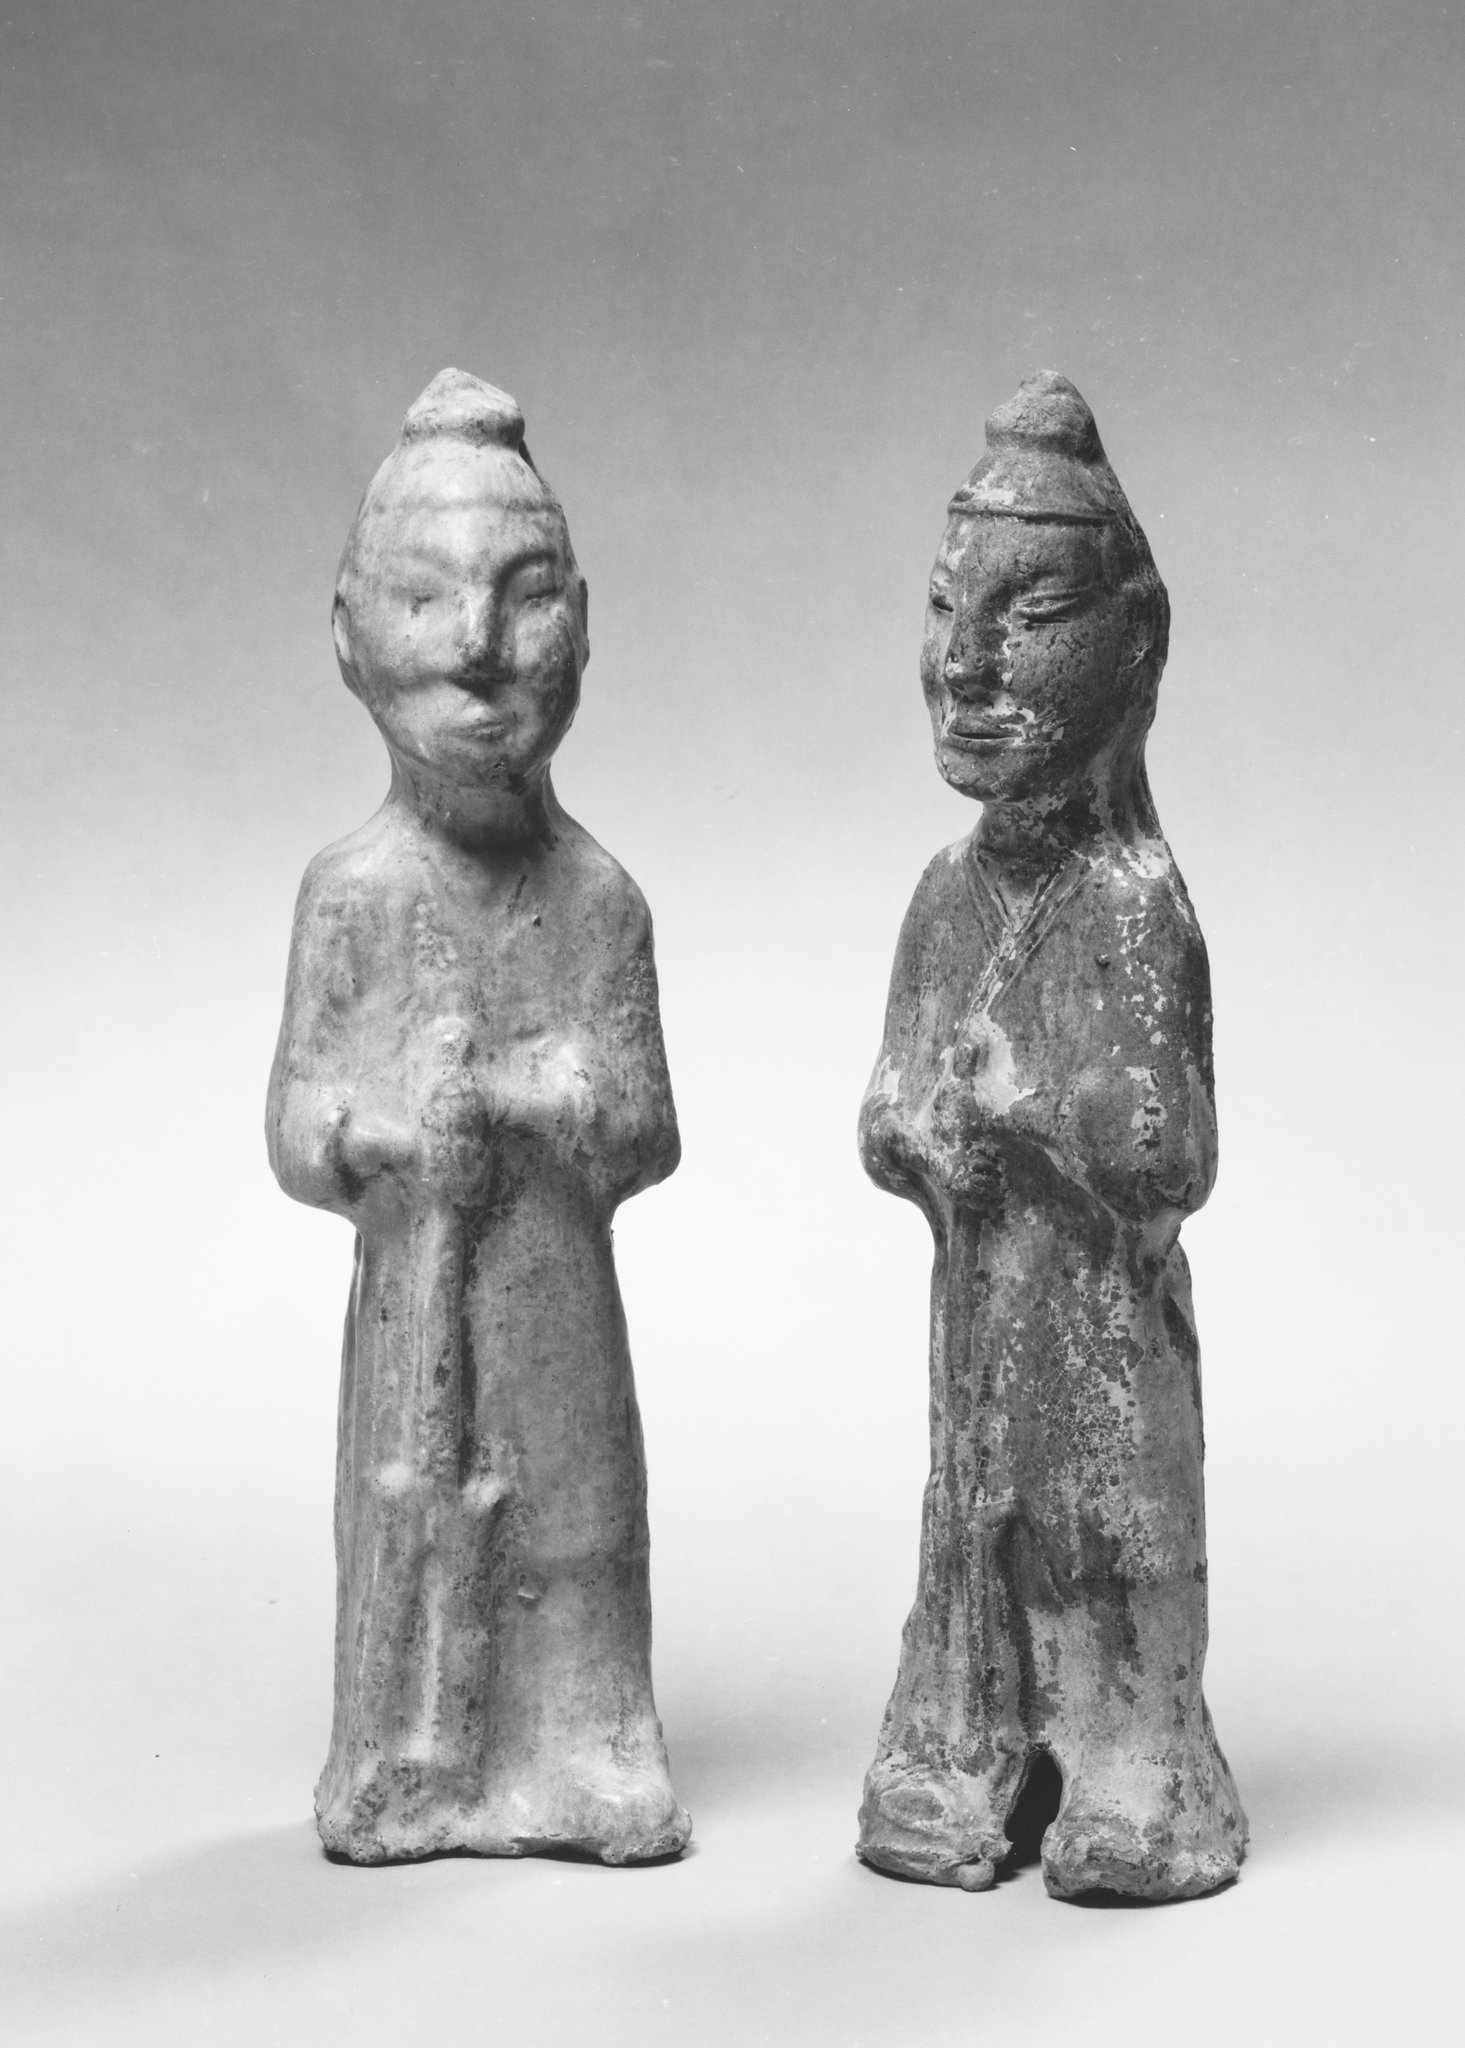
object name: figure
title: Standing Farmer holding a Pitchfork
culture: chinese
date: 10000 BCE-1644 CE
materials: earthenware, glaze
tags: human figures,farmers